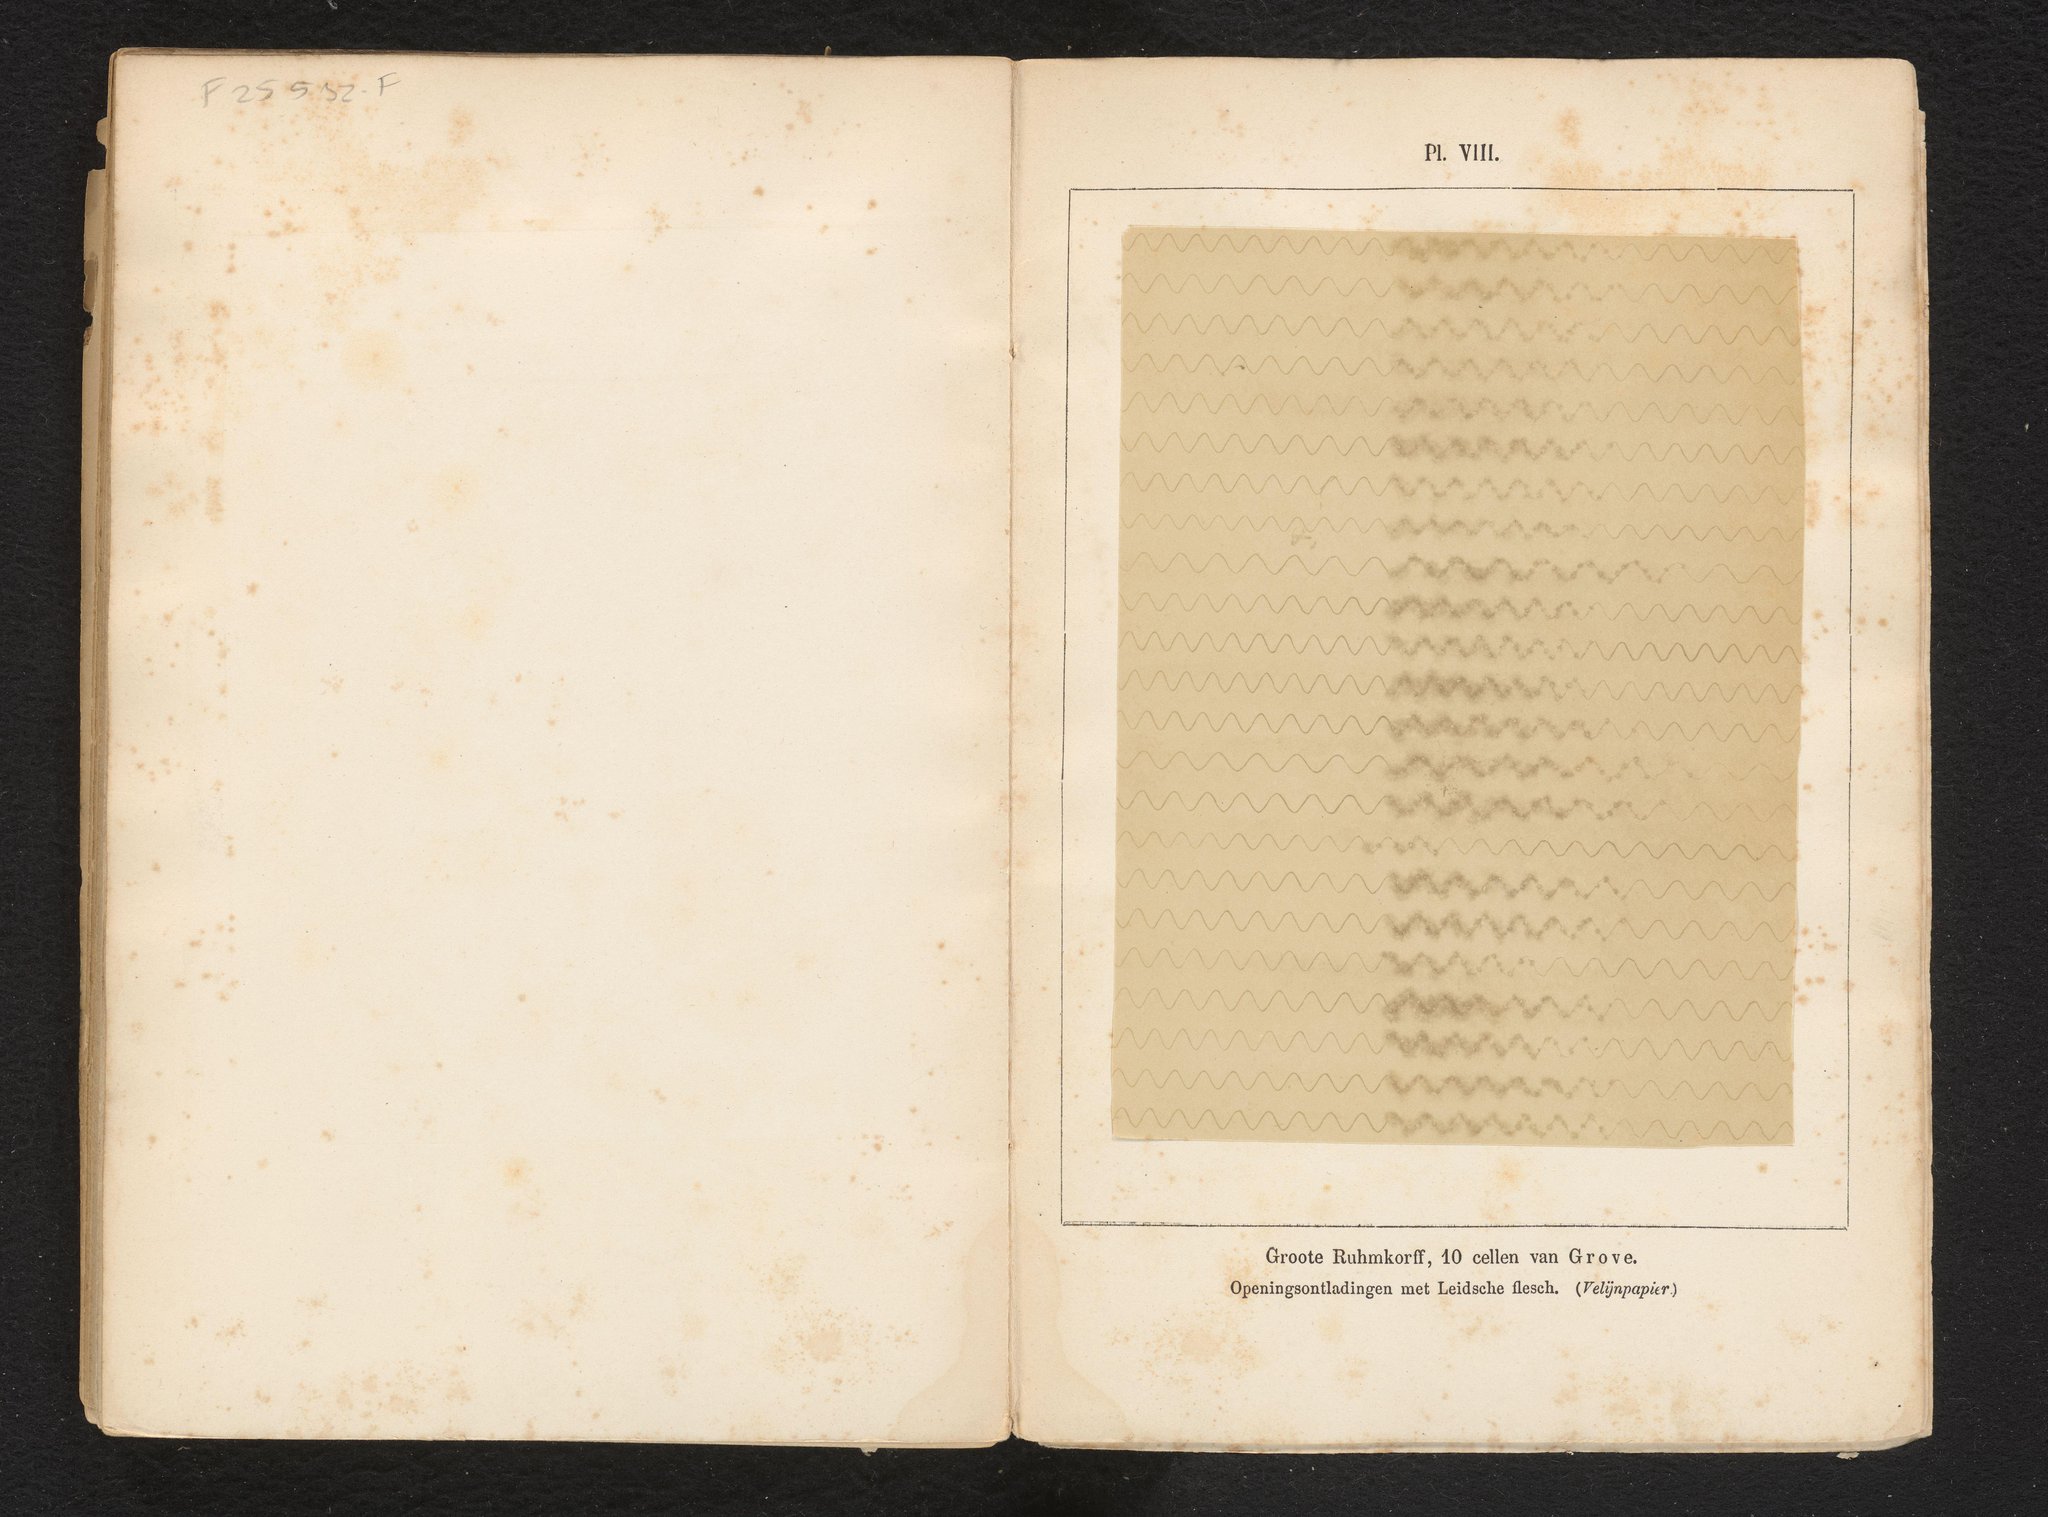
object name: page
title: Registratie van electriciteitsgolven opgewekt door een vonkinductor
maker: willem cornelis van dijk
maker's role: painter, print maker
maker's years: 1826-1881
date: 1865-1870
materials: paper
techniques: albumen print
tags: electrical phenomena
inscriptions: number: ‘Pl. VIII.’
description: Foto op zeventiende ongenummerde pagina na pagina 95.